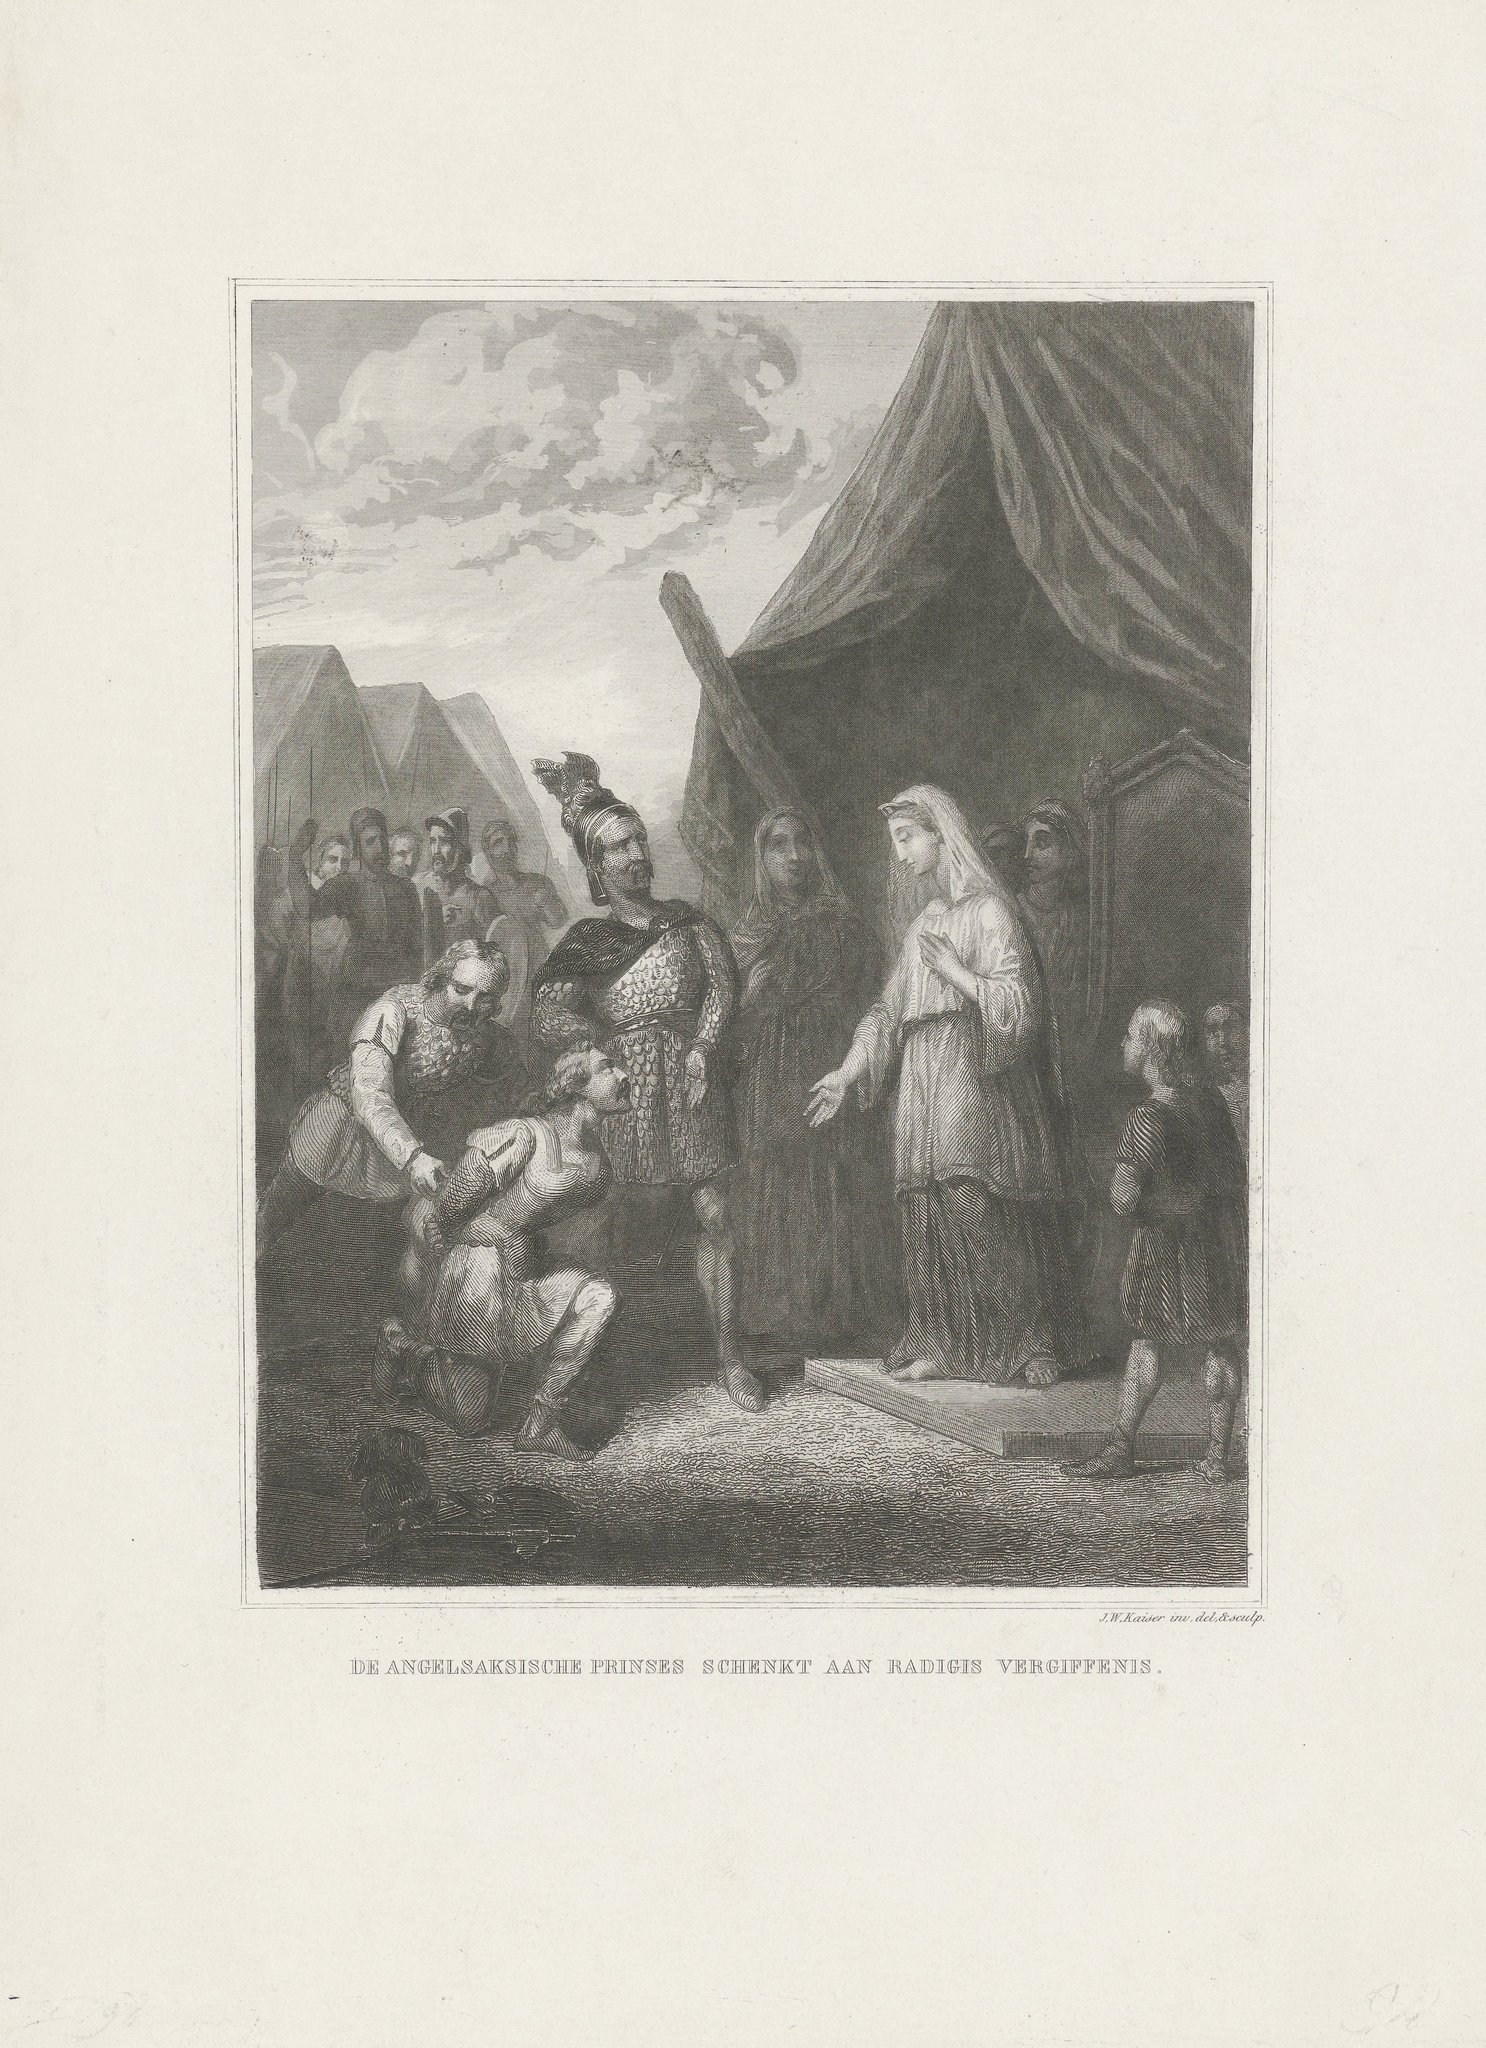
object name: print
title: De Angelsaksische prinses schenkt aan Radigis vergiffenis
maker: johann wilhelm kaiser (i)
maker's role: draughtsman, print maker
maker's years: 1813-1900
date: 1840-1884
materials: paper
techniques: engraving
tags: names of literary characters, land forces, granting mercy; free pardon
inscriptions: collector's mark: Lugt 2228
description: Voor een legerhut ontvangt Radigis, koning van Warmond, in het jaar 534 vergiffenis van zijn verstoten Angelsaksische bruid, nadat zij hem met haar legermacht had overwonnen en gevangen had genomen. Hij toonde berouw over zijn misstap en beloofde met haar te trouwen.